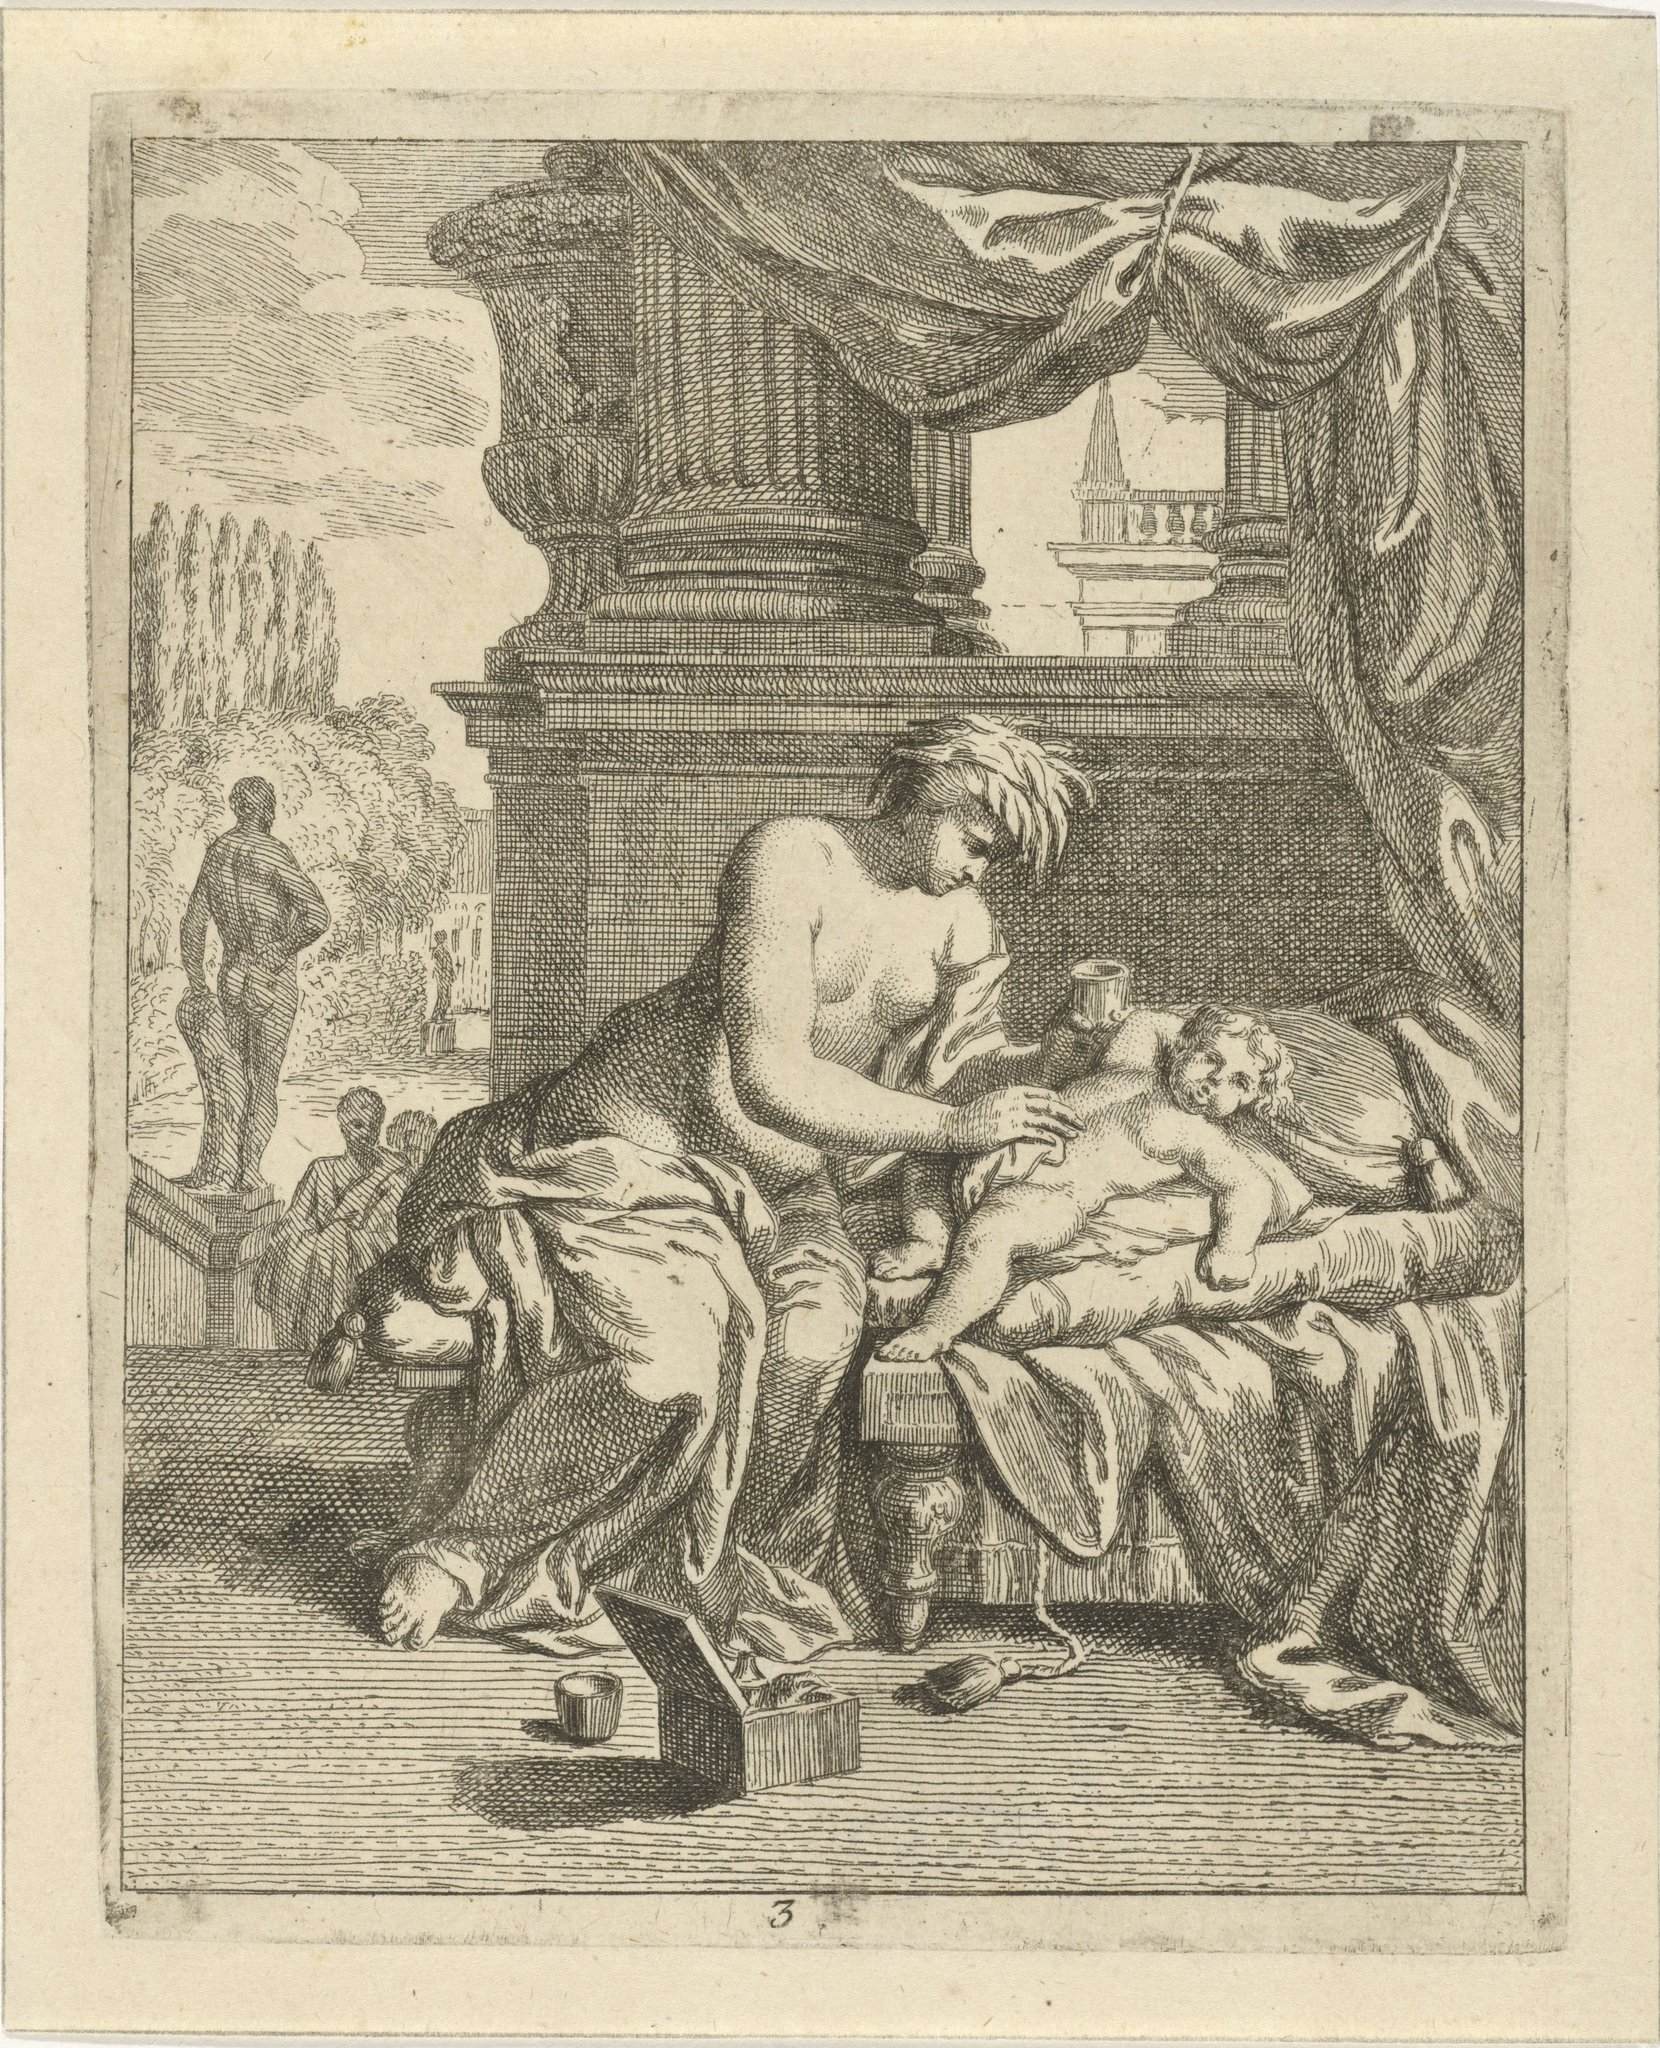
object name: print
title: Vitam et mortem achilli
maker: j. alexander janssens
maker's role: print maker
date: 1700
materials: paper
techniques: engraving, etching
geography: southern netherlands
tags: infancy, upbringing of achilles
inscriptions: collector's mark: Lugt 2228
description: Thetis smeert haar sterfelijke kind Achilles in met ambrosia, in de hoop hem onsterfelijk te maken. Ze zit op een ligbed op een balustrade. Op de voorgrond een doos met daarin de ambrosiabladeren. Op de achtergrond nadert Peleus. Midden onder: 3. Derde prent uit een serie van veertien met scènes uit het leven van Achilles.